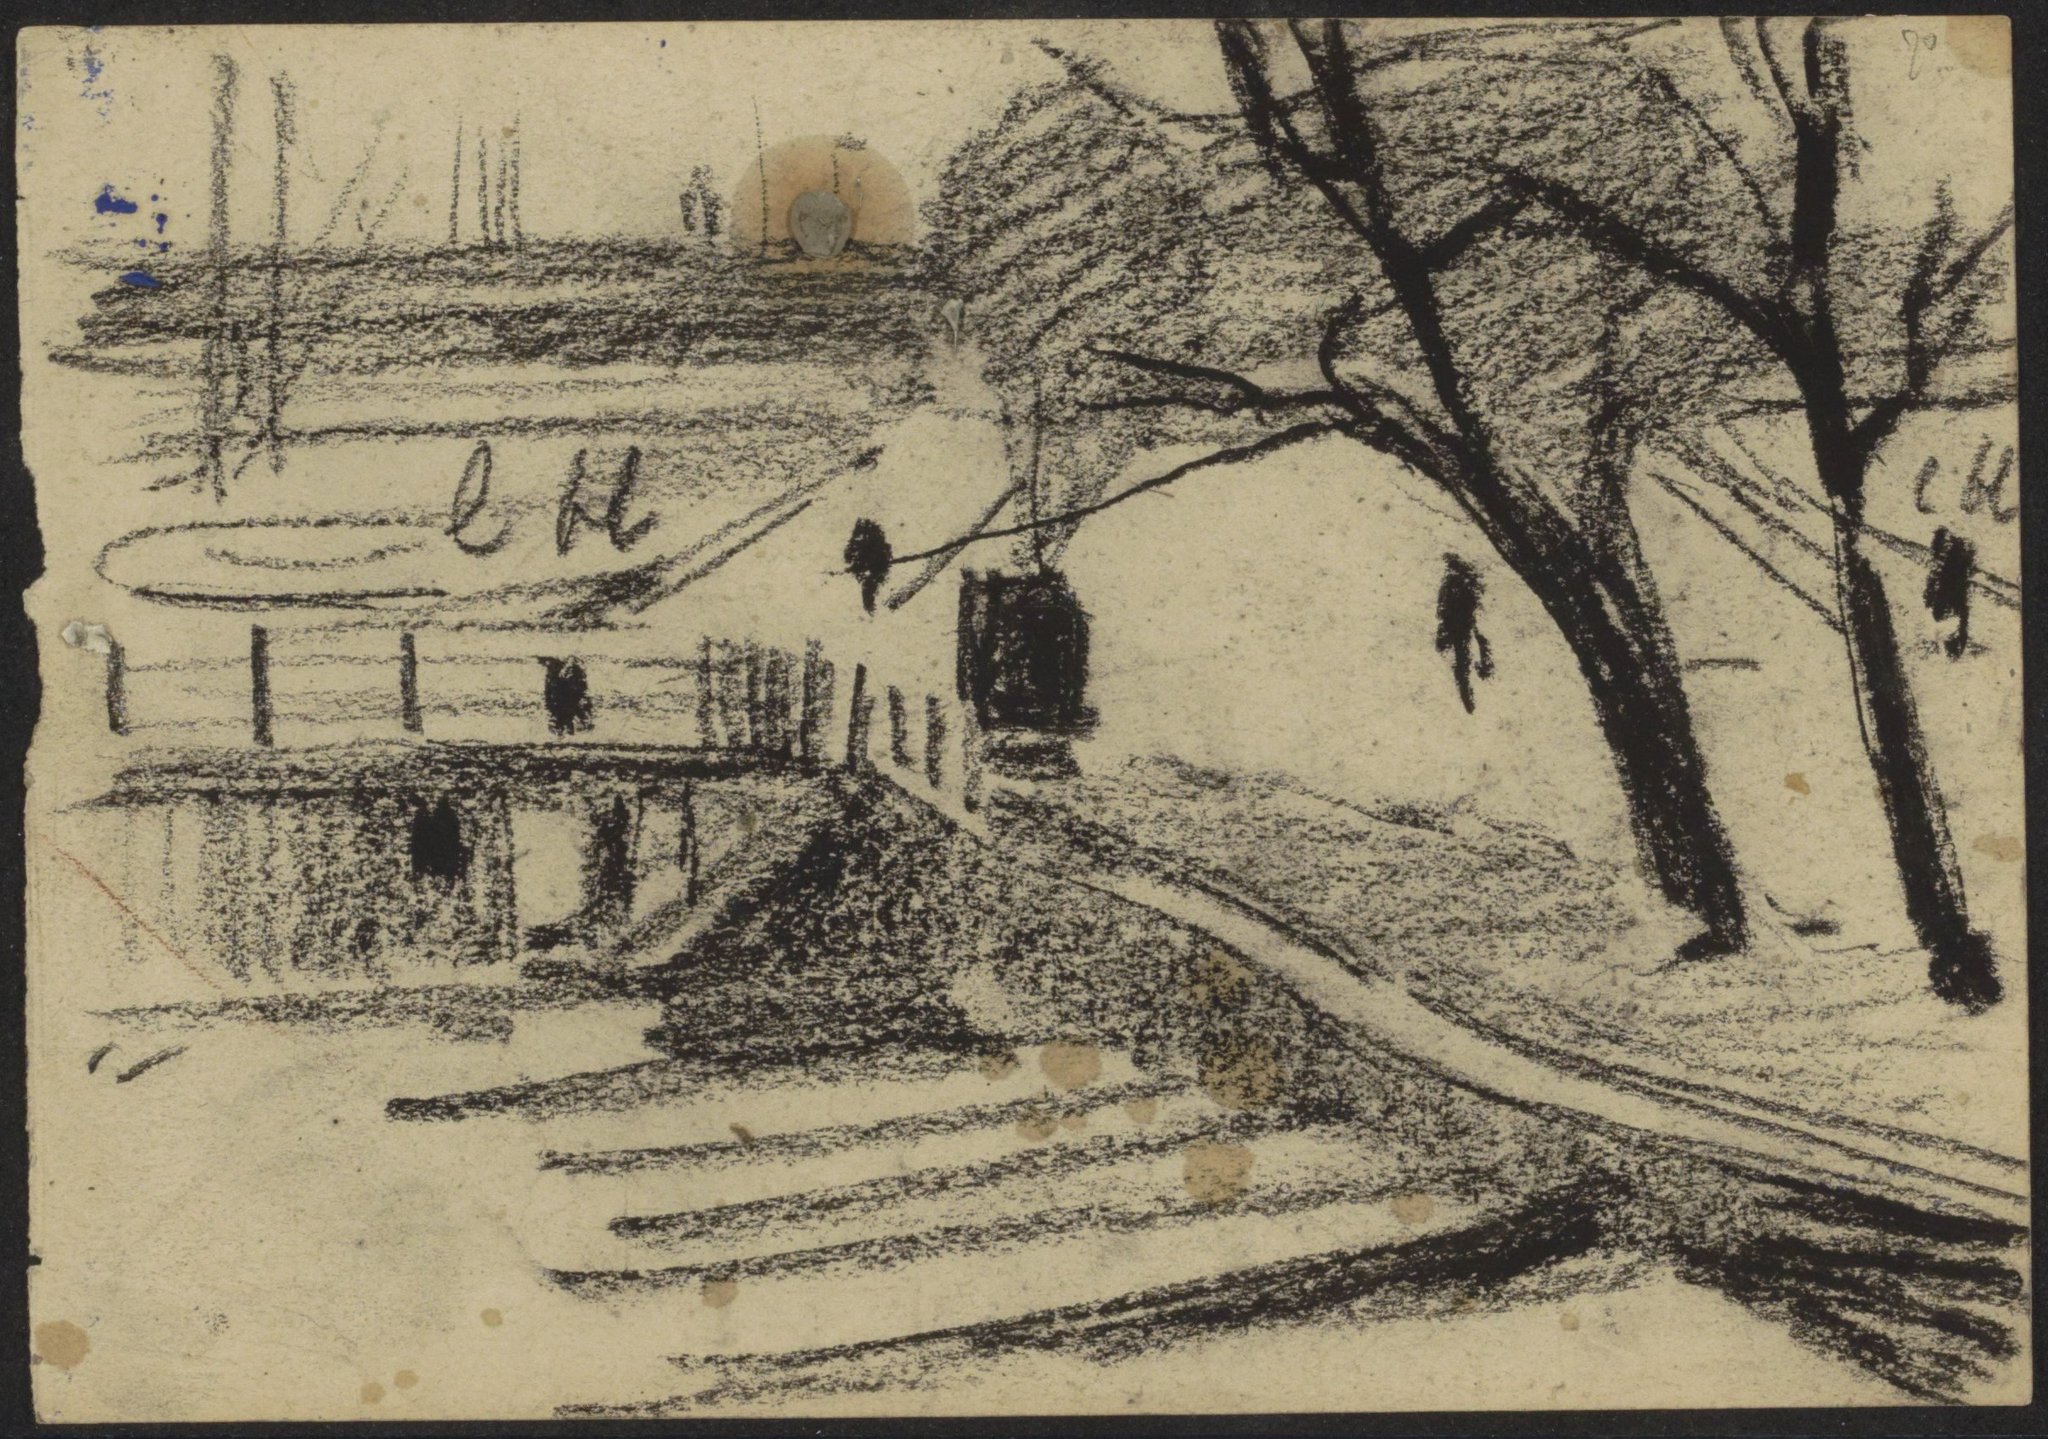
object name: sketchbook leaf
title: Figuren en bomen op een kade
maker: willem witsen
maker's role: draughtsman, painter, print maker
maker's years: 1860-1923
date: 1870-1923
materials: chalk, paper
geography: amsterdam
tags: trees, quay (+ city(-scape) with figures, staffage), amsterdam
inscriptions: : ‘[...]’